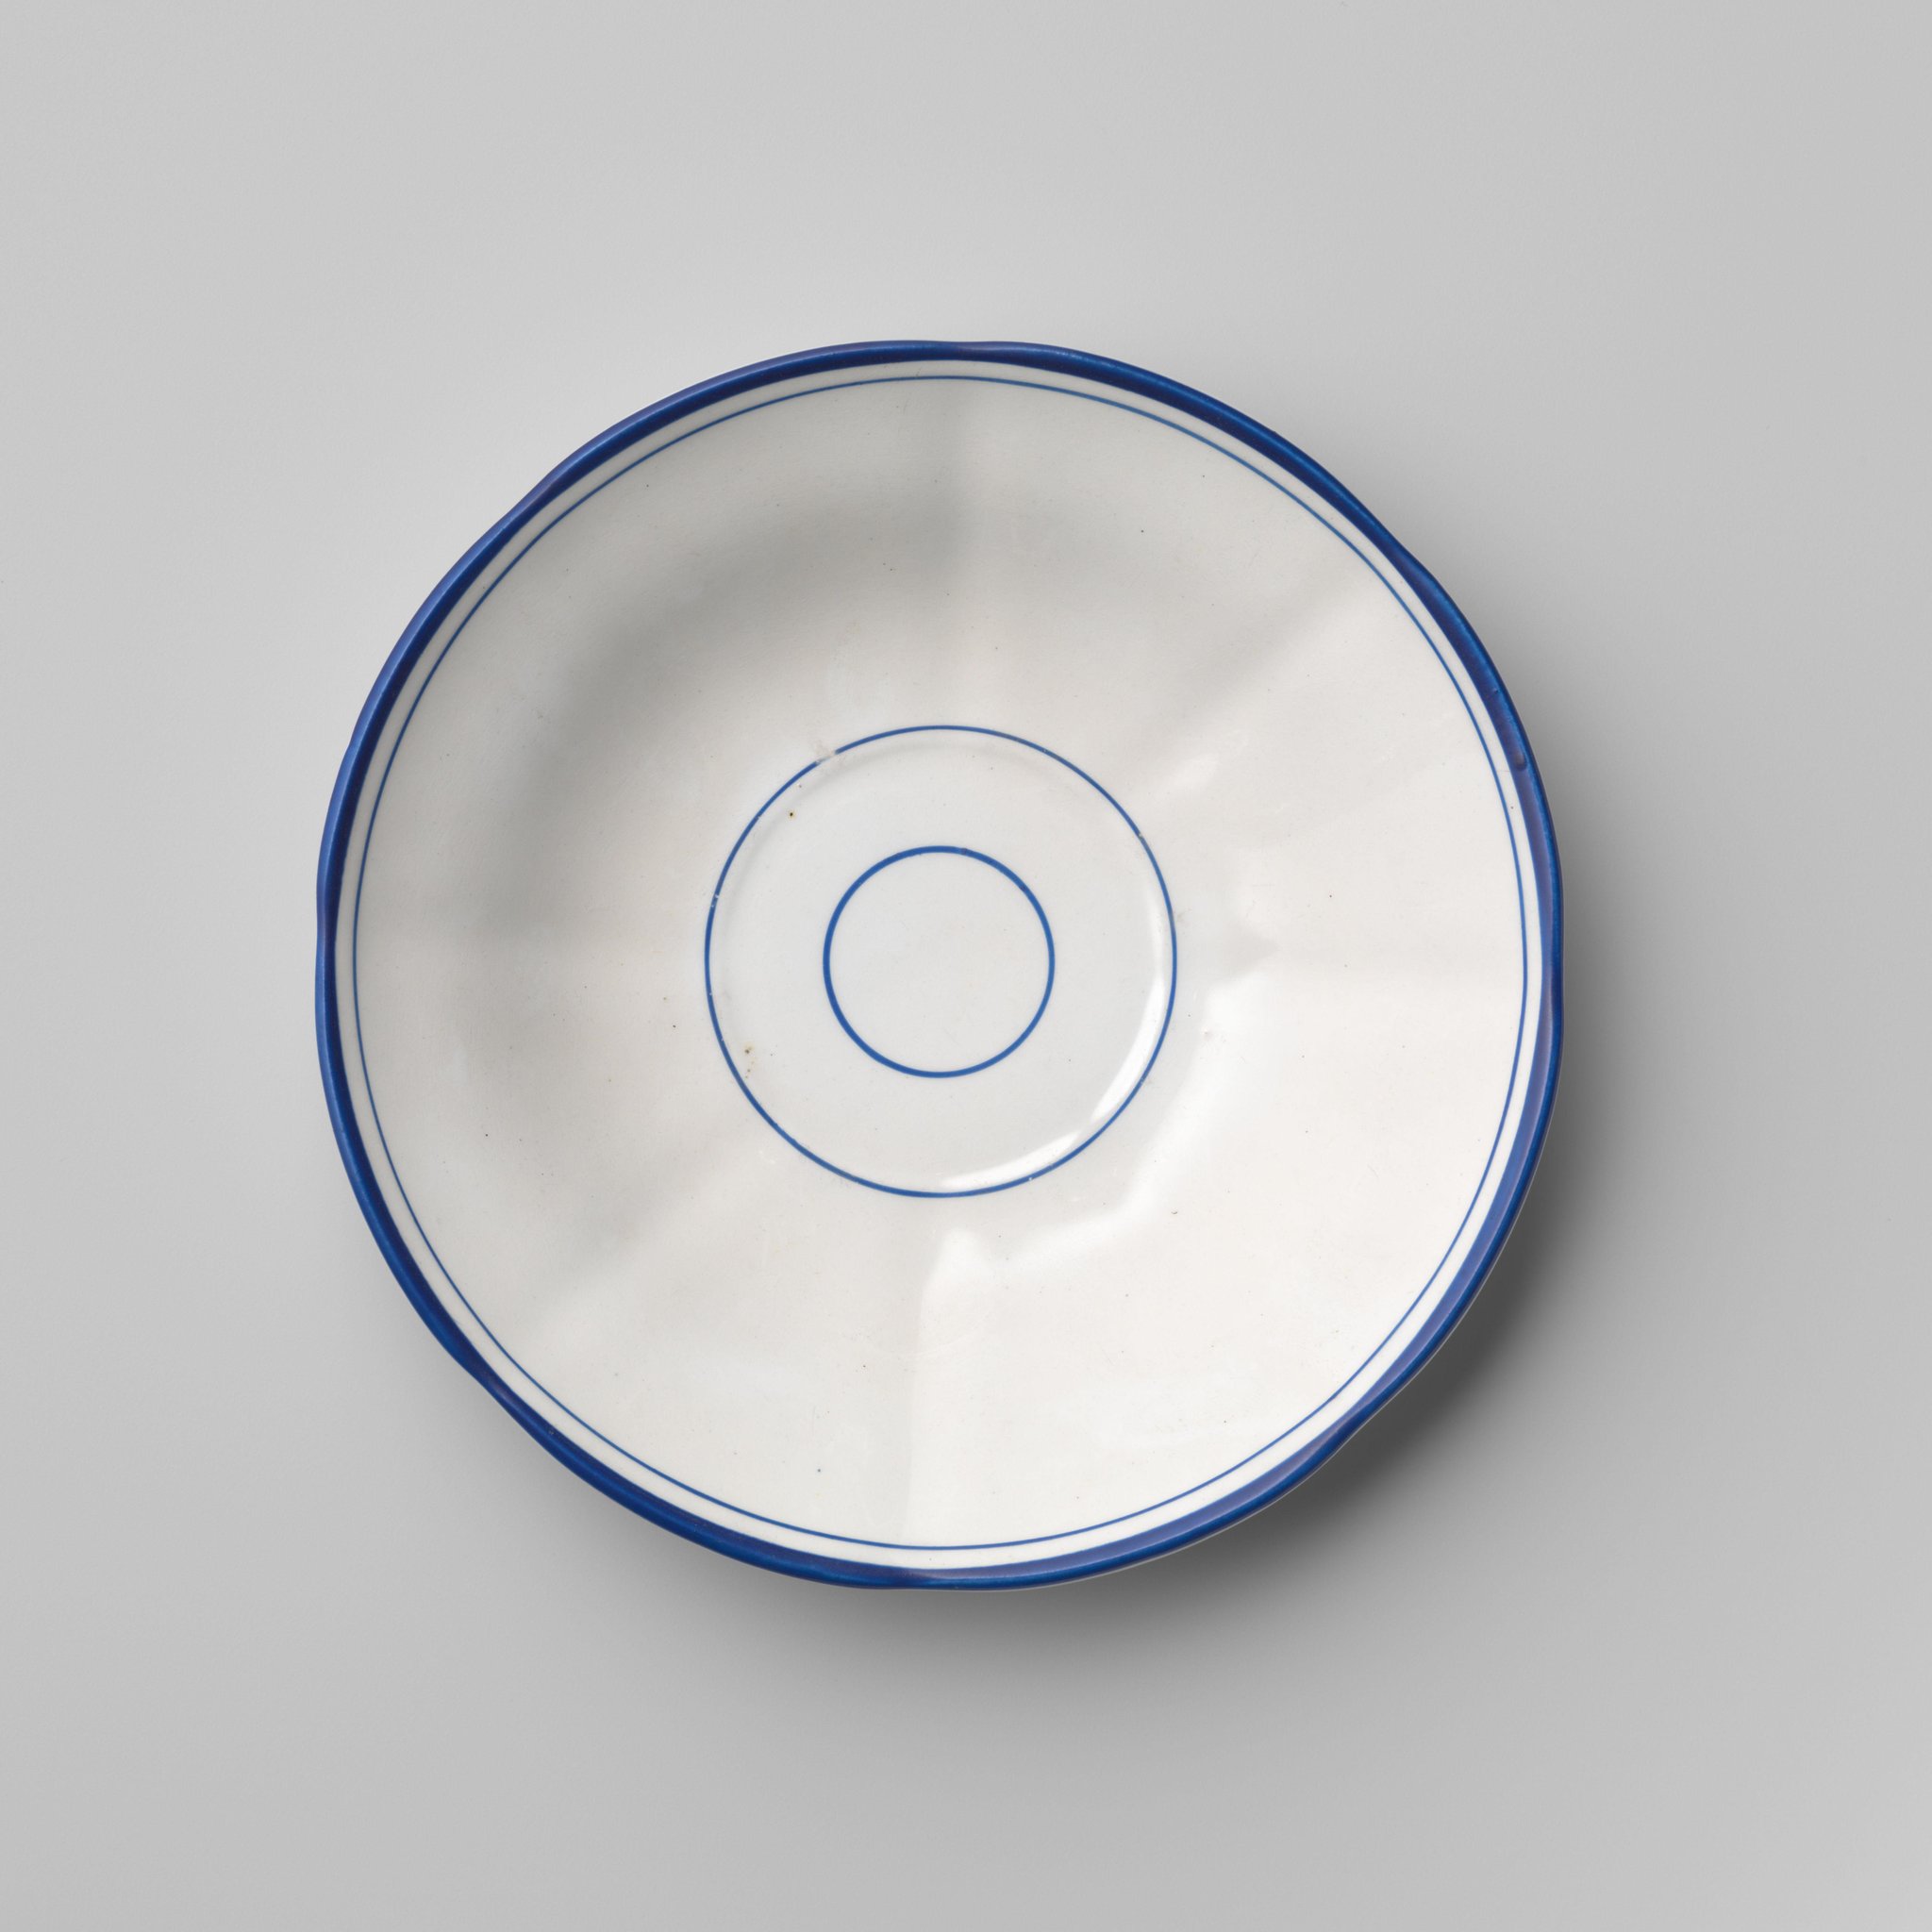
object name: platter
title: Schotel, wit, met blauwe biezen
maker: petrus regout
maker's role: plateelbakker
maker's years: 1801-1879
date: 1860-1890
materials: creamware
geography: maastricht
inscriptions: check stamp: ‘P. REGOUT // MAASTRICHT // 10X’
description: Schotel van aardewerk, behorend bij een koffie- en theeservies, wit, met blauwe biezen op het plat en de rand.